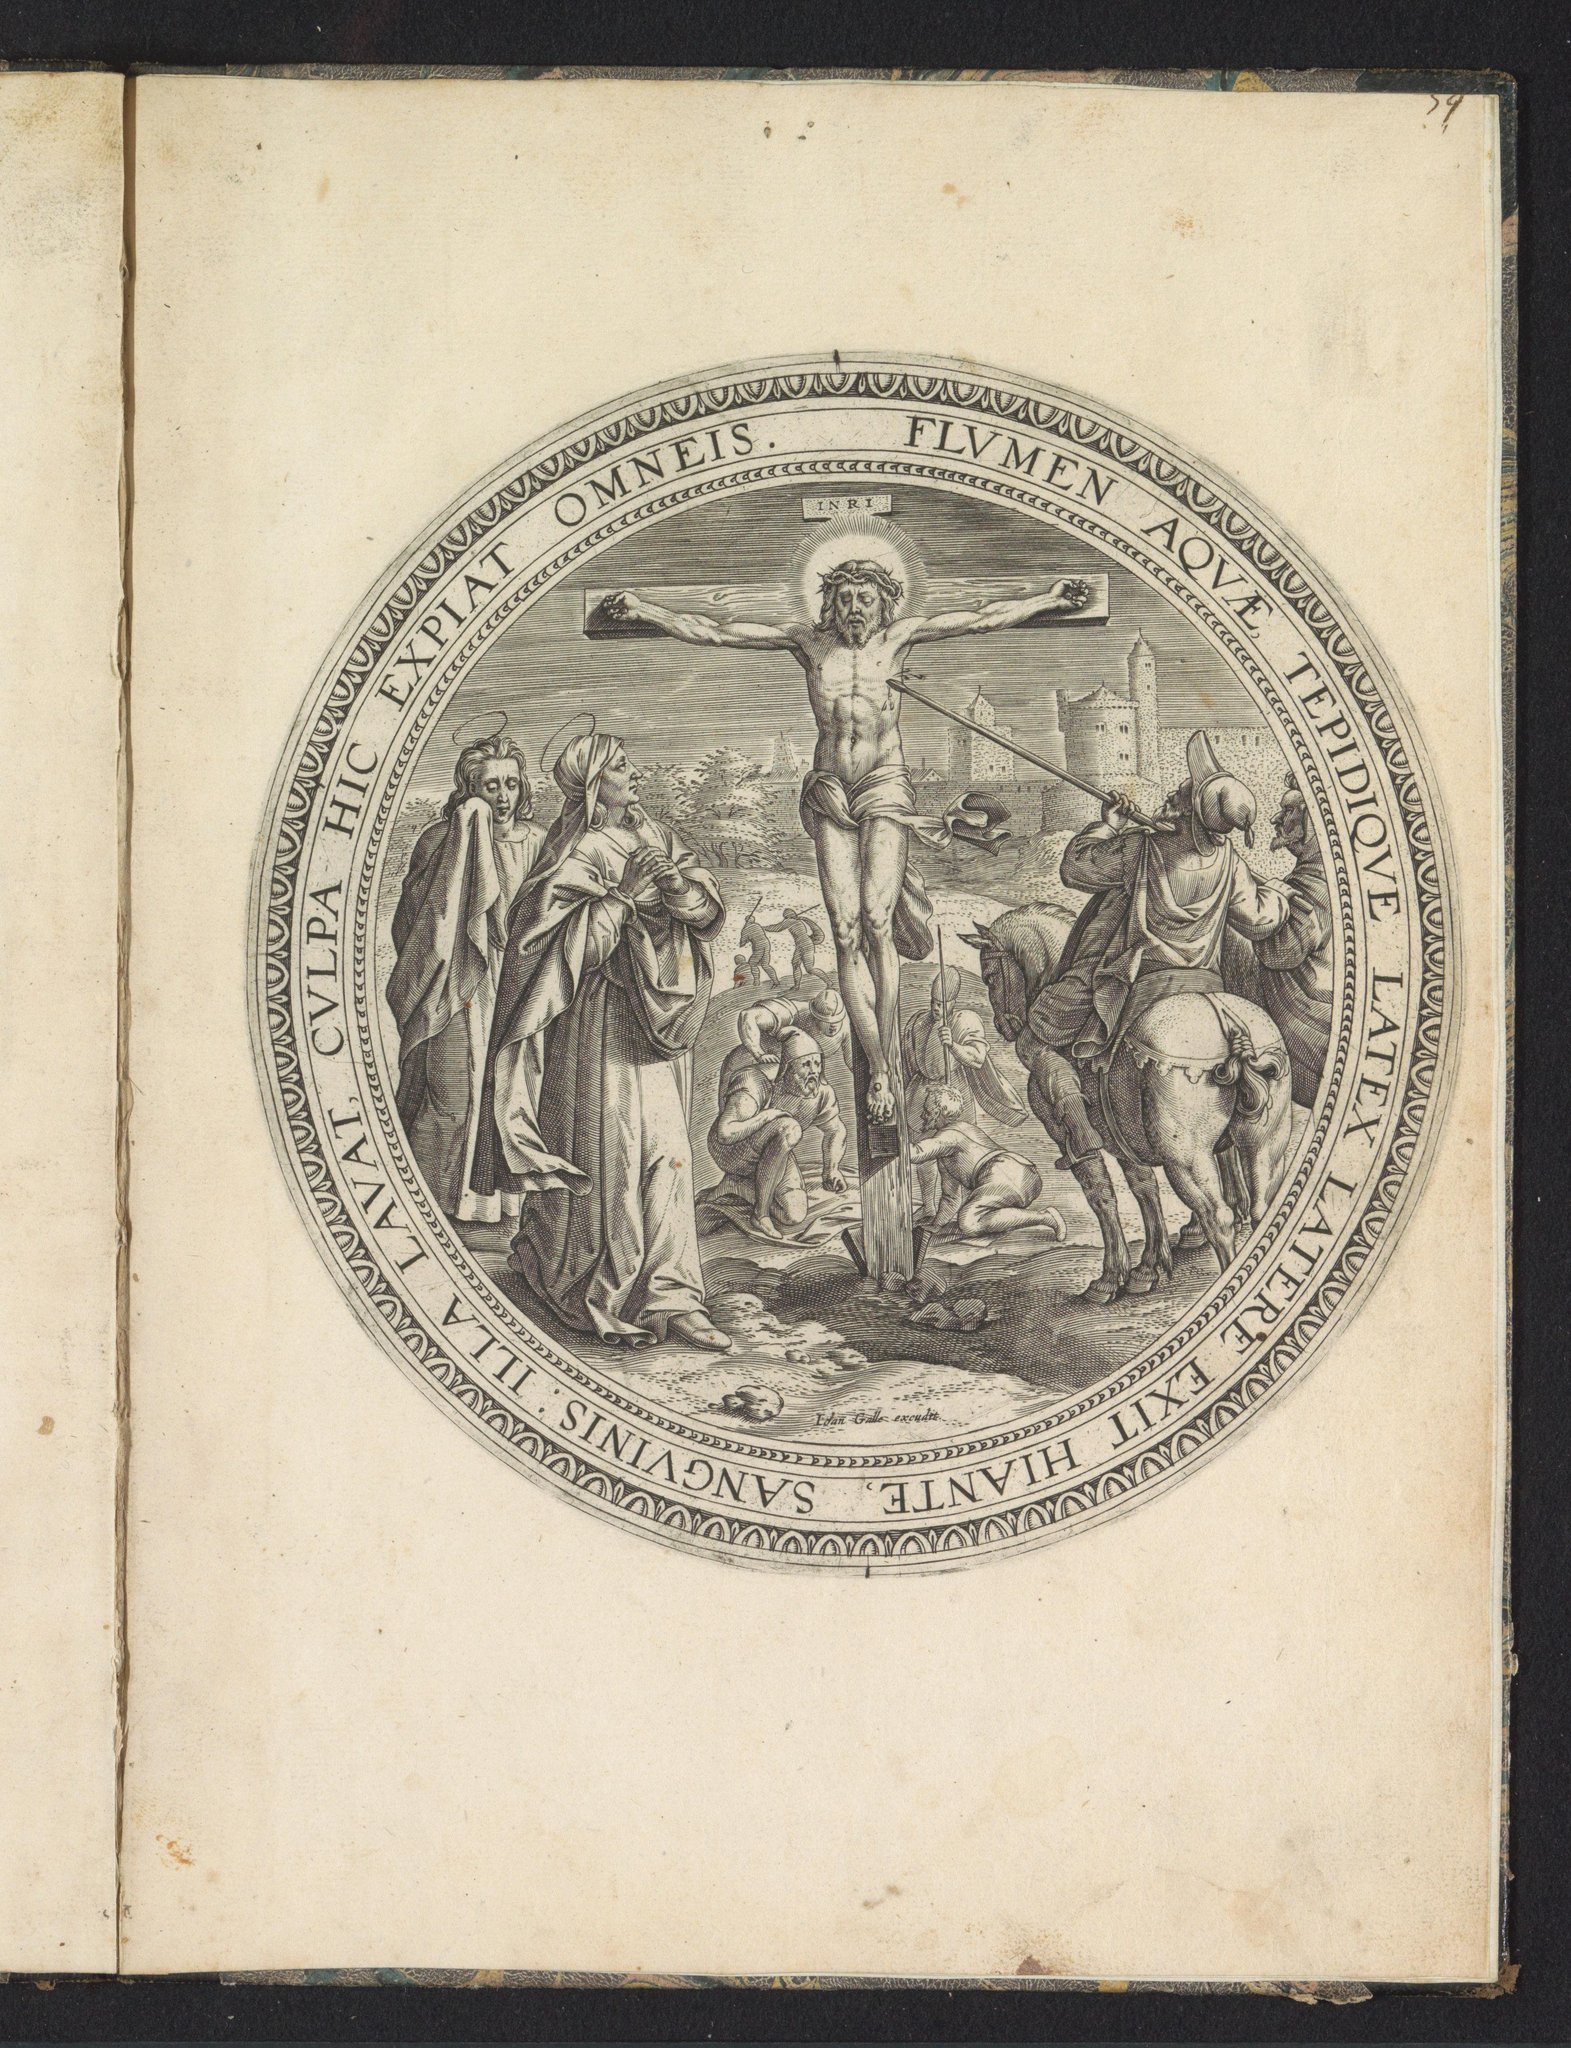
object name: print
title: Christus aan het kruis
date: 1580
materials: paper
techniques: engraving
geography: antwerp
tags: longinus pierces christ's side with a lance, single scenes of the seven bleedings of christ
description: Christus hangt aan het kruis en Longinus steekt hem met een speer in de zij. Prent uit prentalbum met zeven ronde gravures met de zeven bloedstortingen van Christus met randschriften.